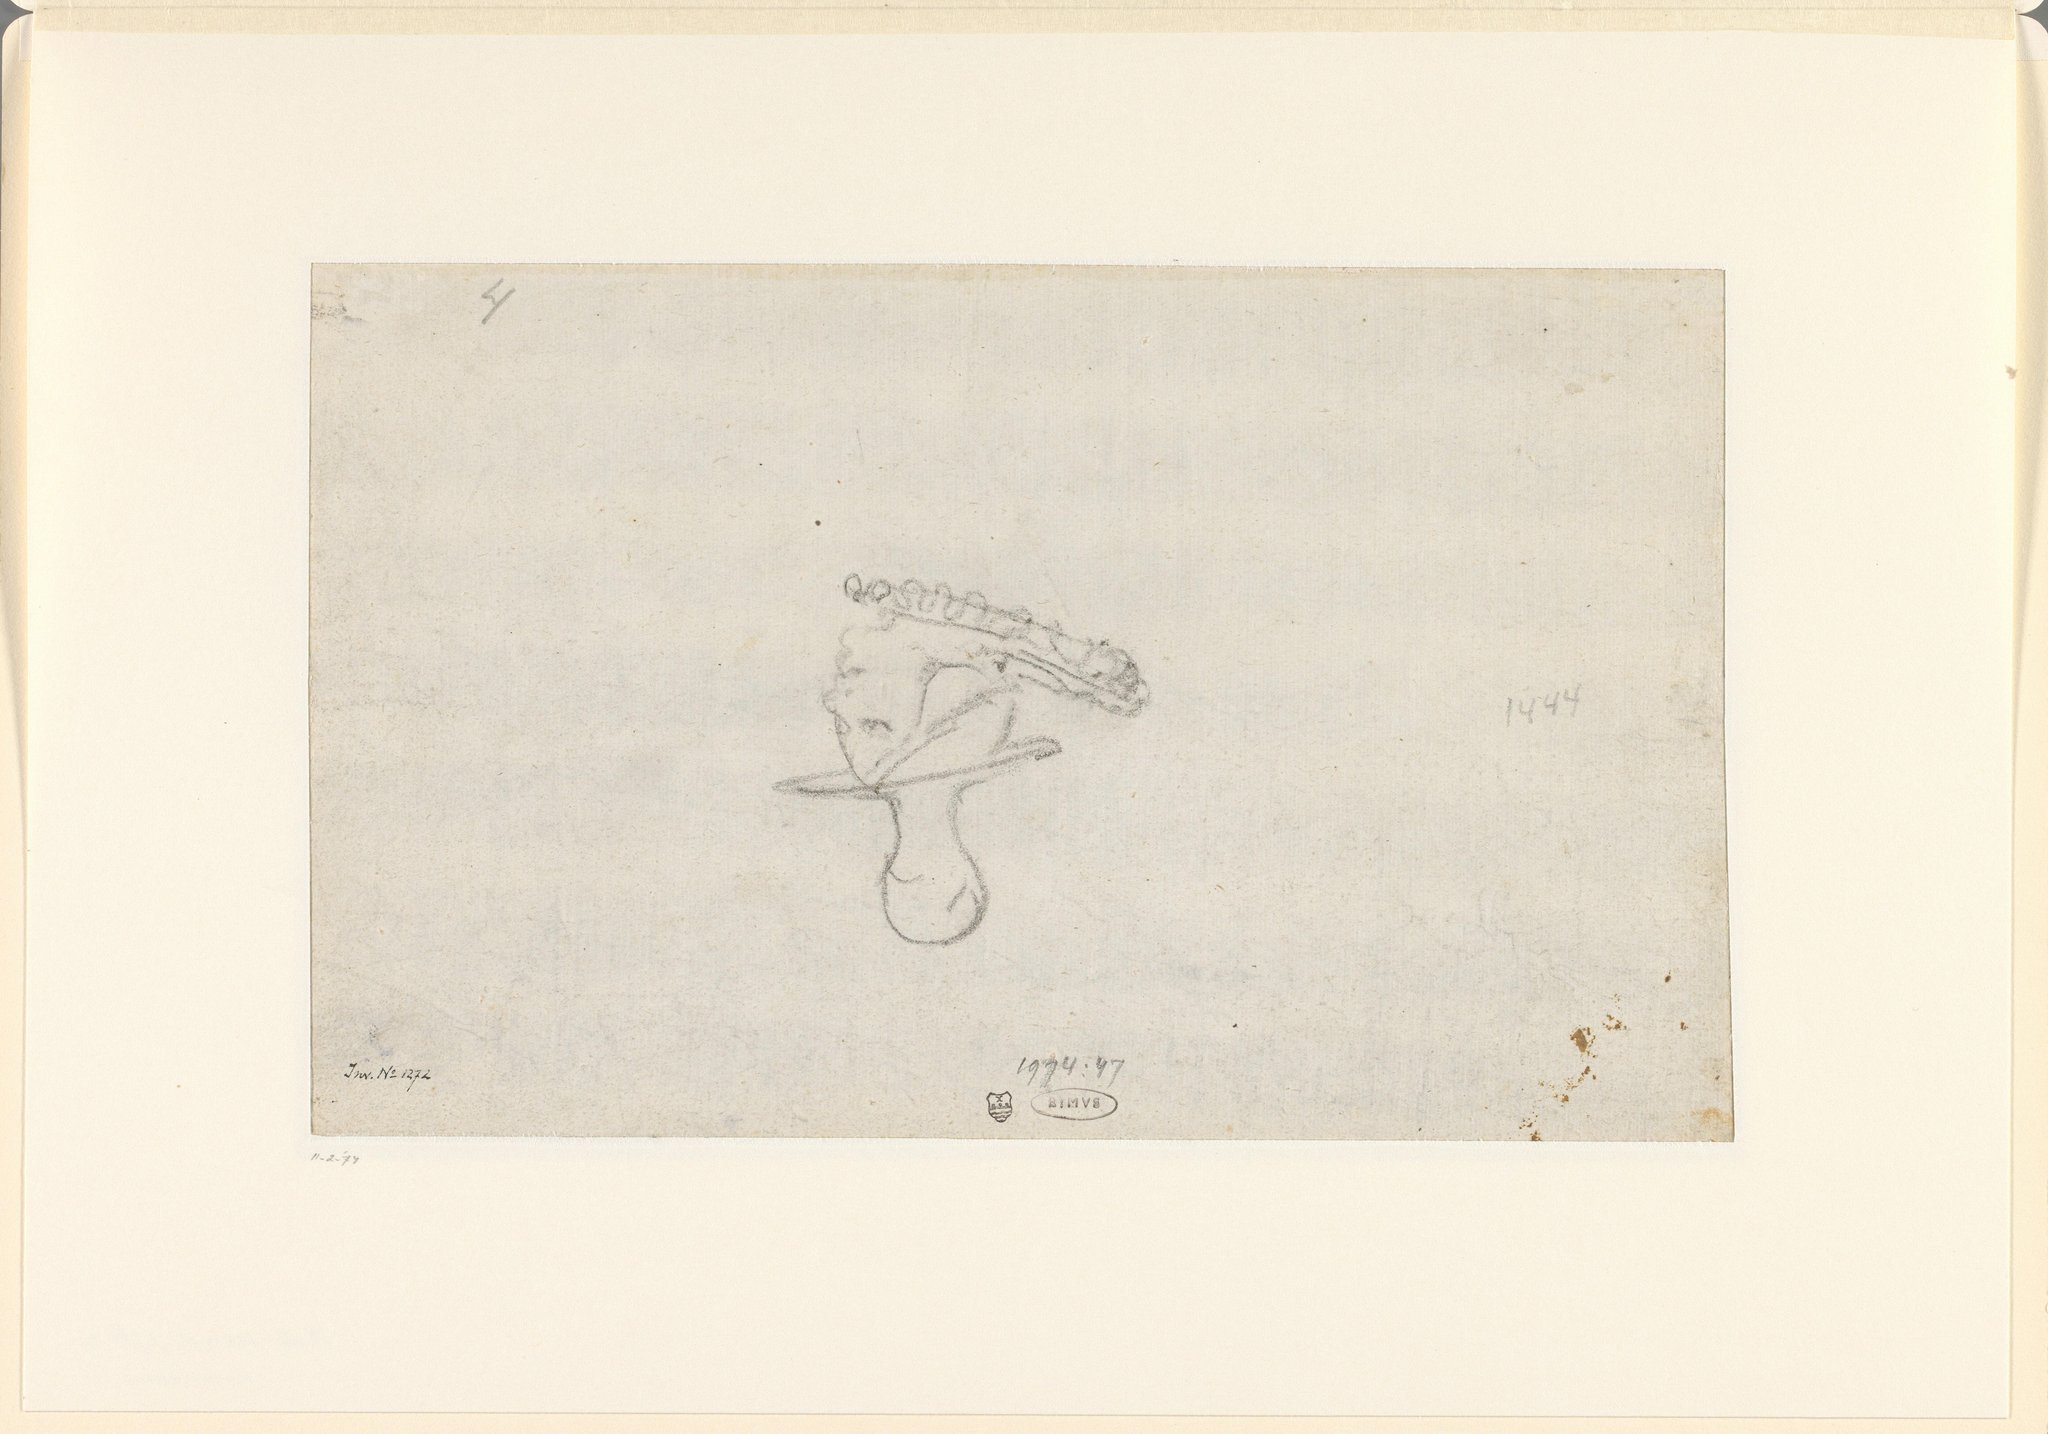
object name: drawing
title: Schets van een vrouwenkopje met stijve plooikraag en hoge hoofdtooi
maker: Anonymous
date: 1600-1699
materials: chalk, paper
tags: head (human), adult woman